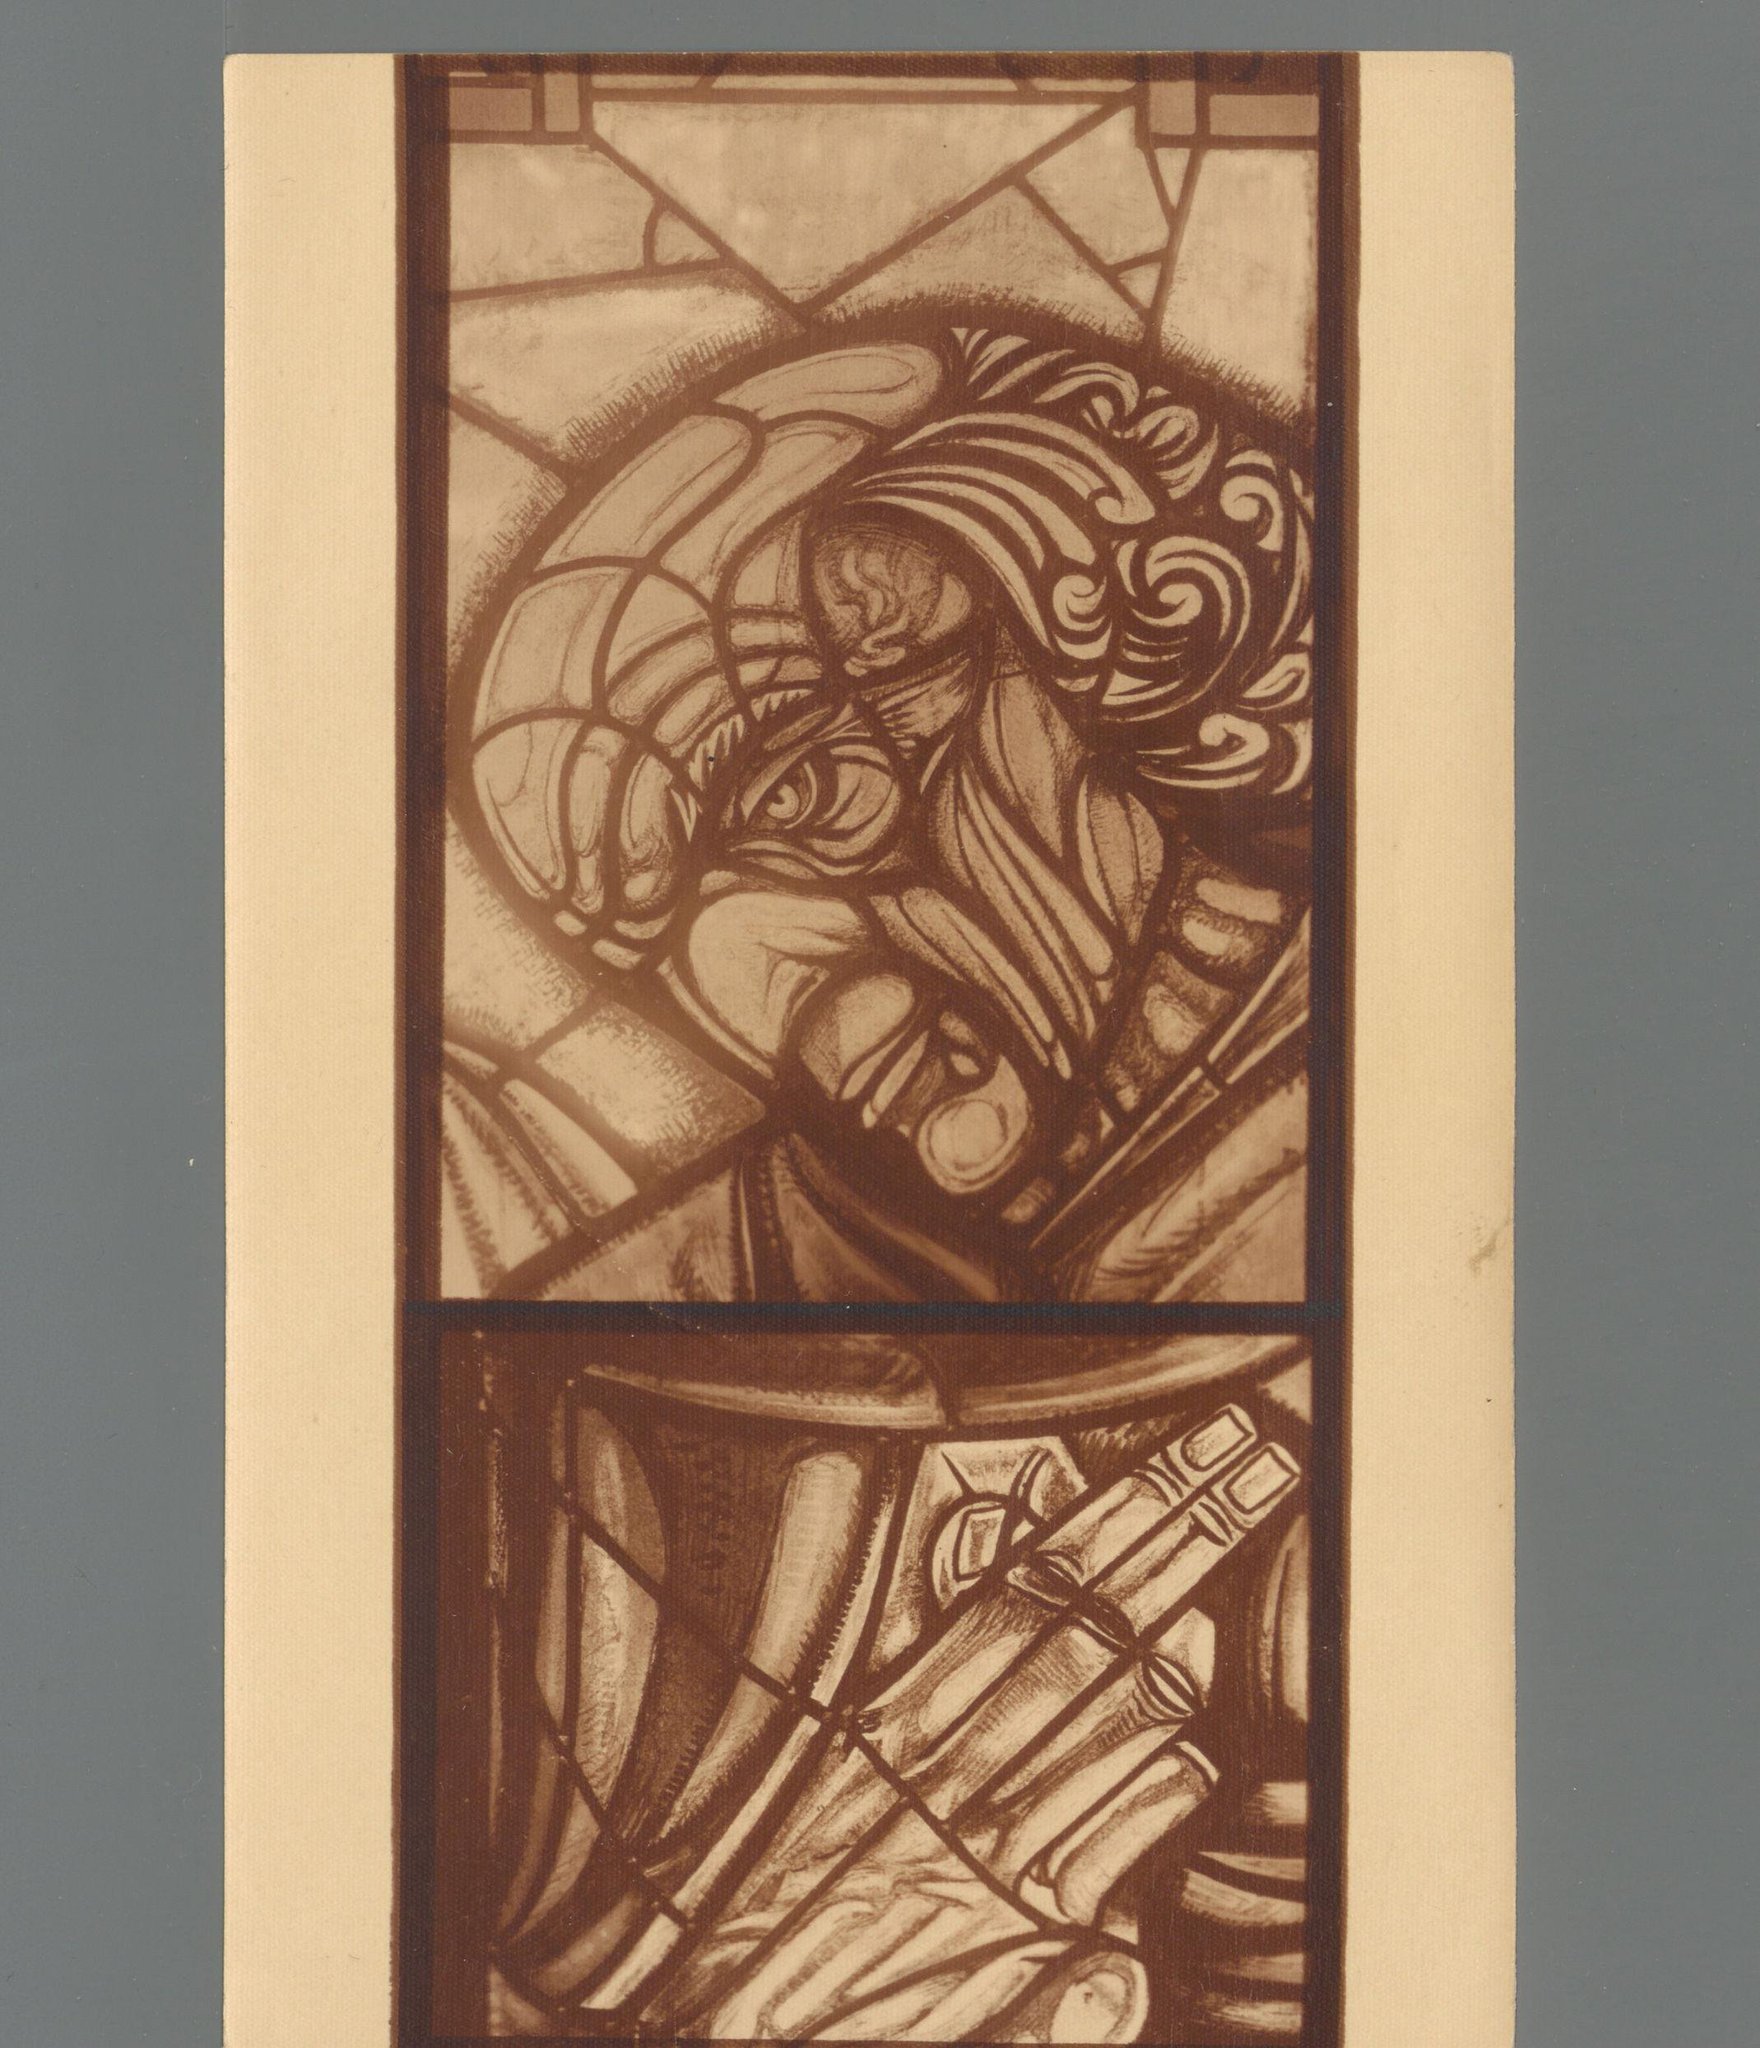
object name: ansichtkaart, prentbriefkaart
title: Evangelist Johannes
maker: Anonymous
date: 1907-1933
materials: paper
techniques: gelatin silver print, writing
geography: dresden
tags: evangelists, usually with books or scrolls (not in biblical context) - ii - the evangelists without their symbols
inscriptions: collector's mark: ‘AFE v S’